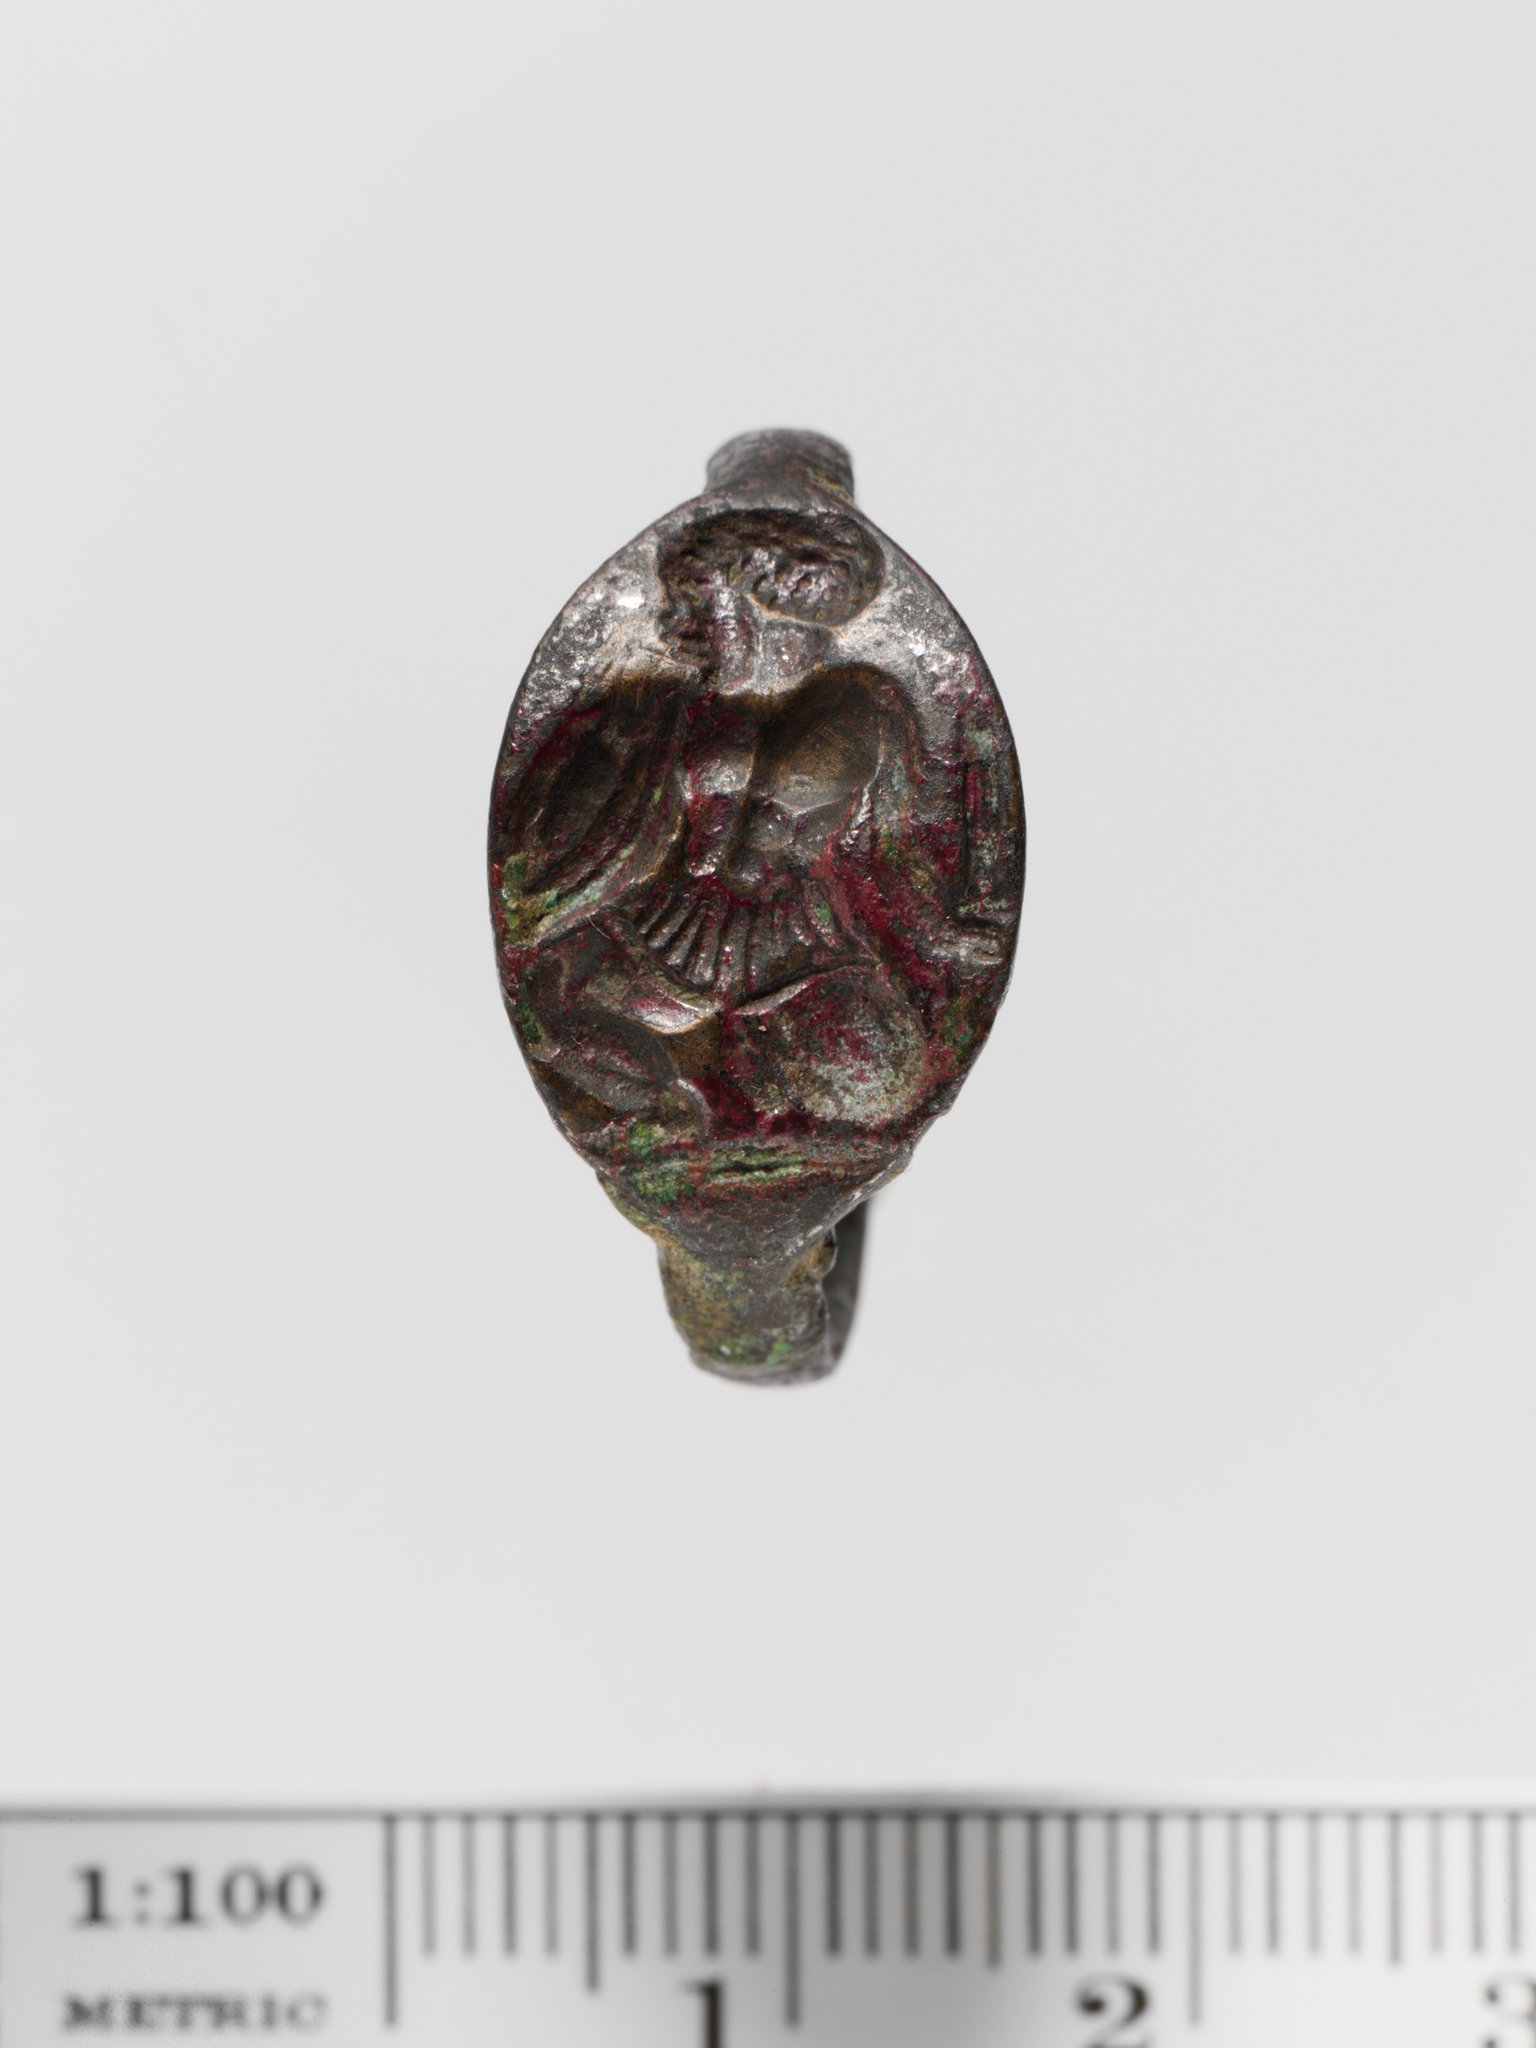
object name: ring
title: Bronze ring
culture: greek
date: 400-301 BCE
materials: bronze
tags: warriors